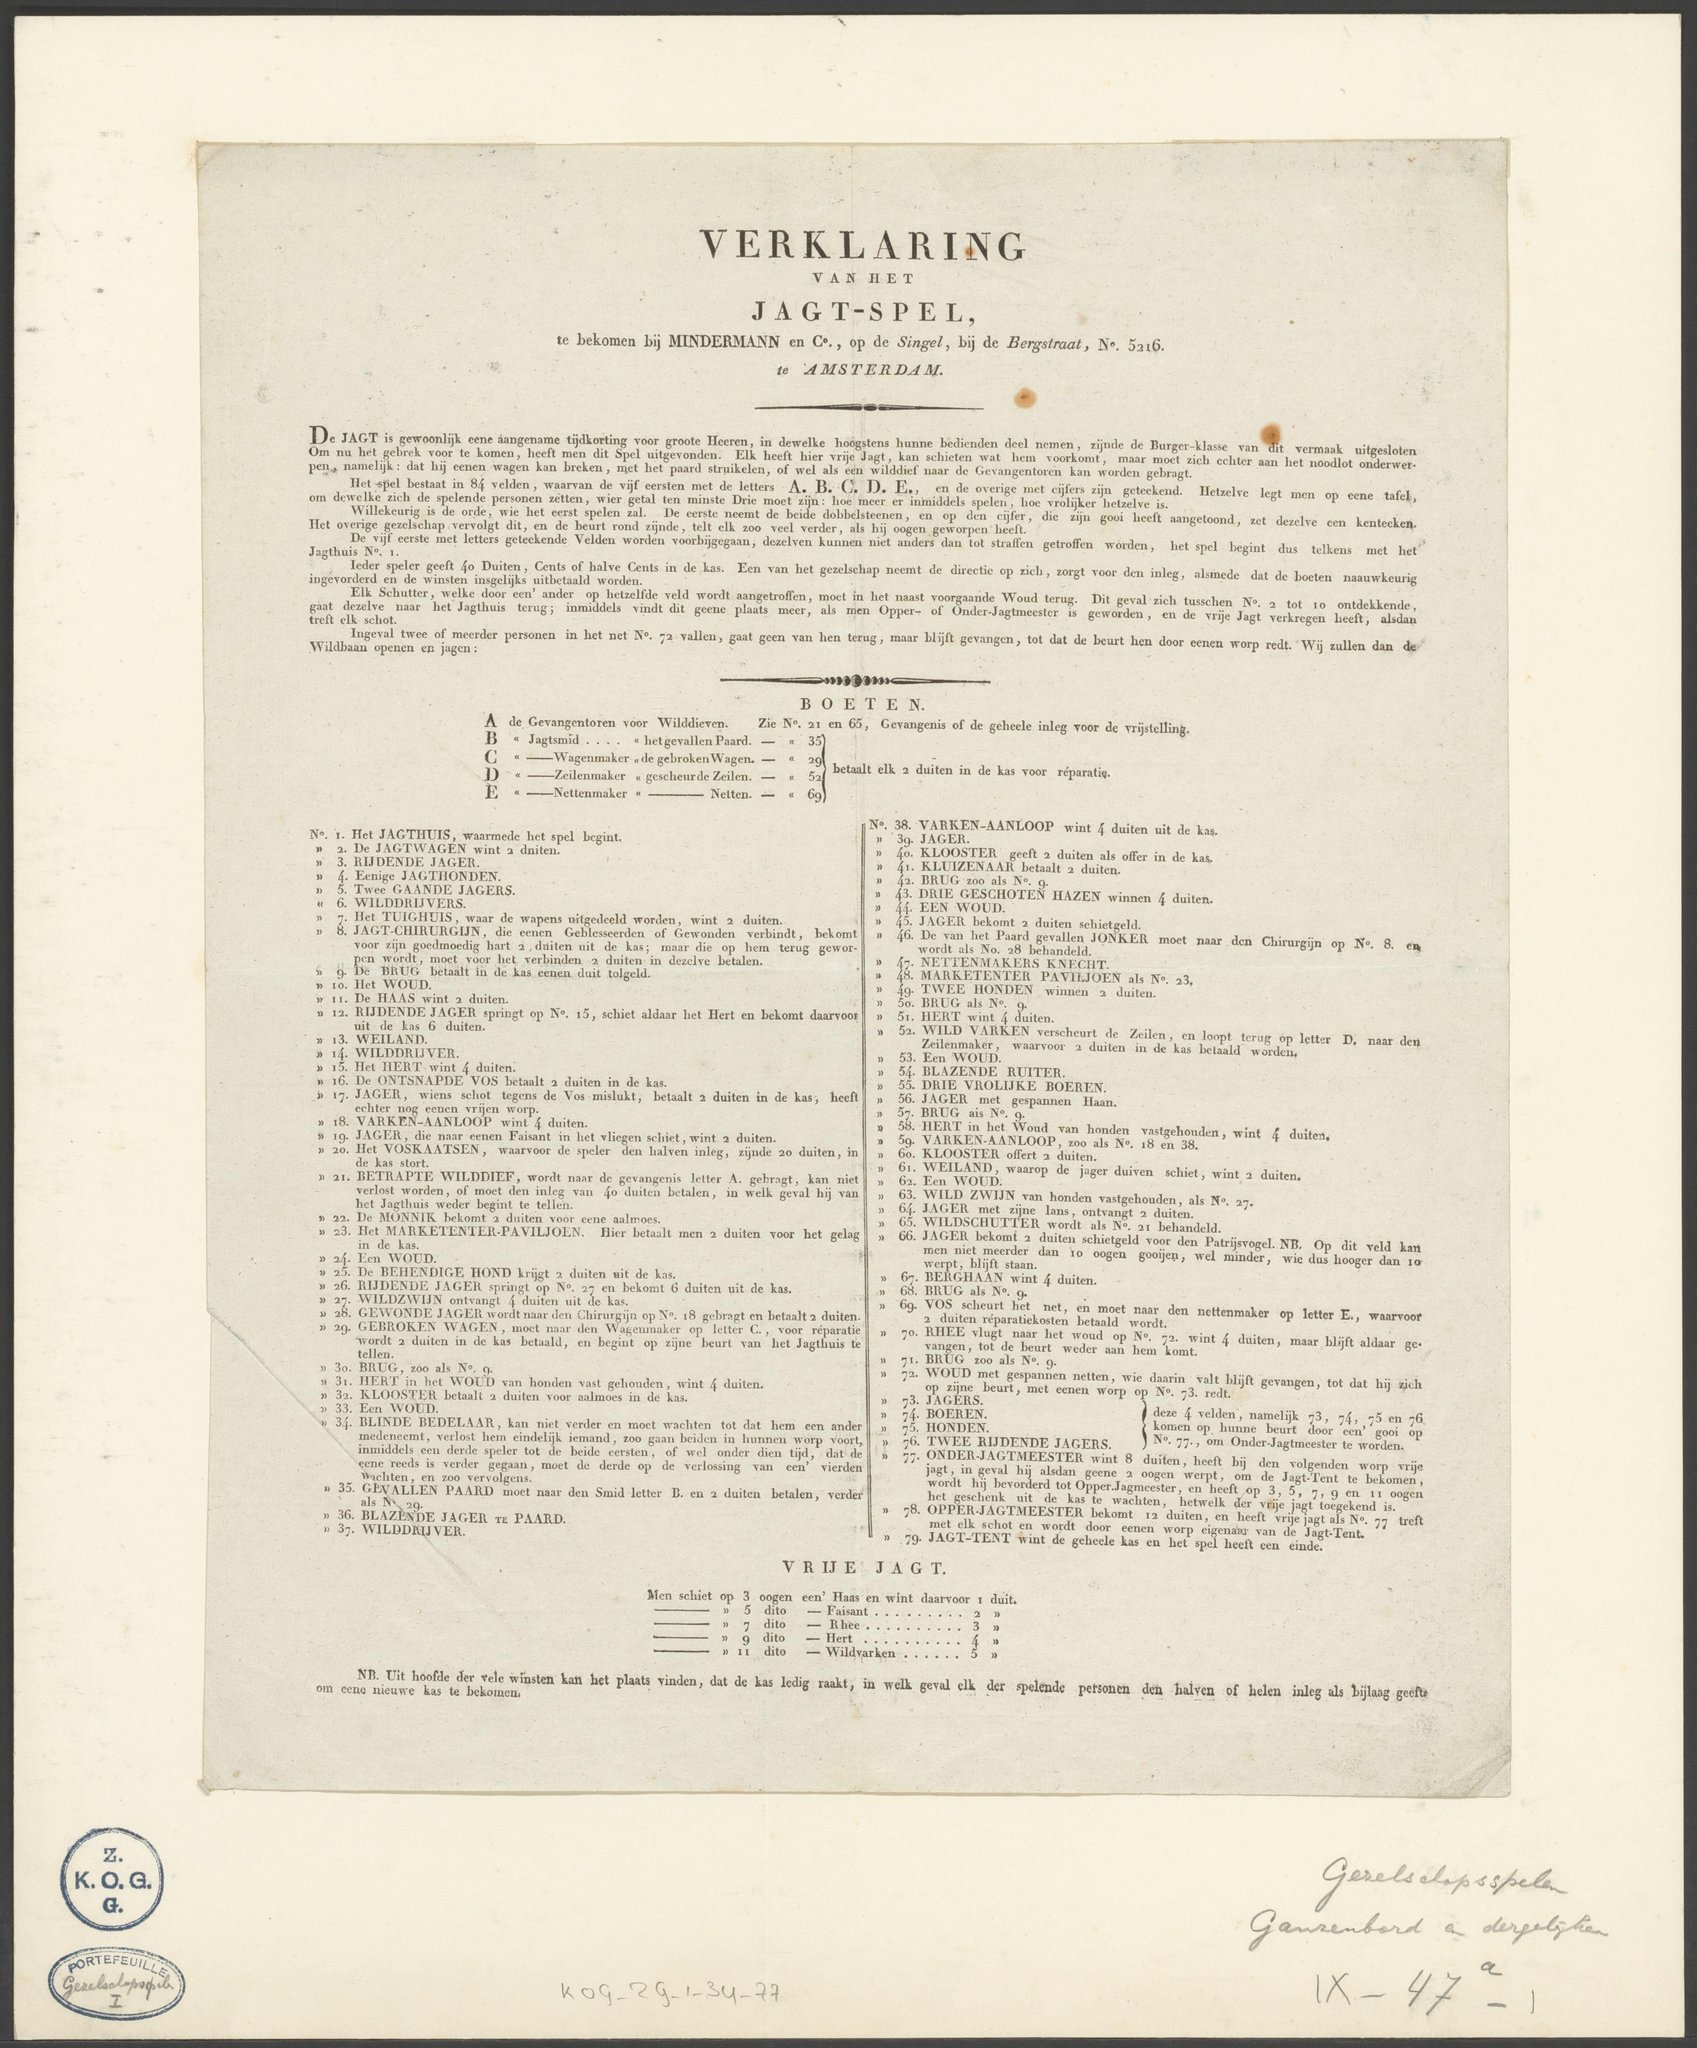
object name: text sheet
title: Verklaring van het Jagt-spel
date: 1819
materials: paper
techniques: letterpress printing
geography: amsterdam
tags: goose-game, hunting, chase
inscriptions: collector's mark: Lugt 1641, collector's mark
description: Tekstblad met spelregels behorende bij het jachtspel. Onderwerpsrubrieken binnen de Atlas Zeden en Gewoonten: Spel en Vermaak; gezelschapsspel, ganzenbord en dergelijke.